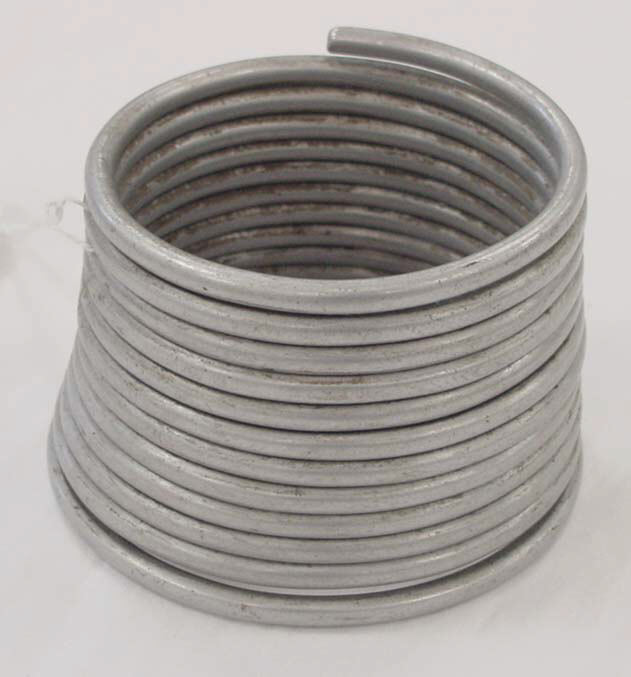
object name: bracelet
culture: african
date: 1801-1900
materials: metal